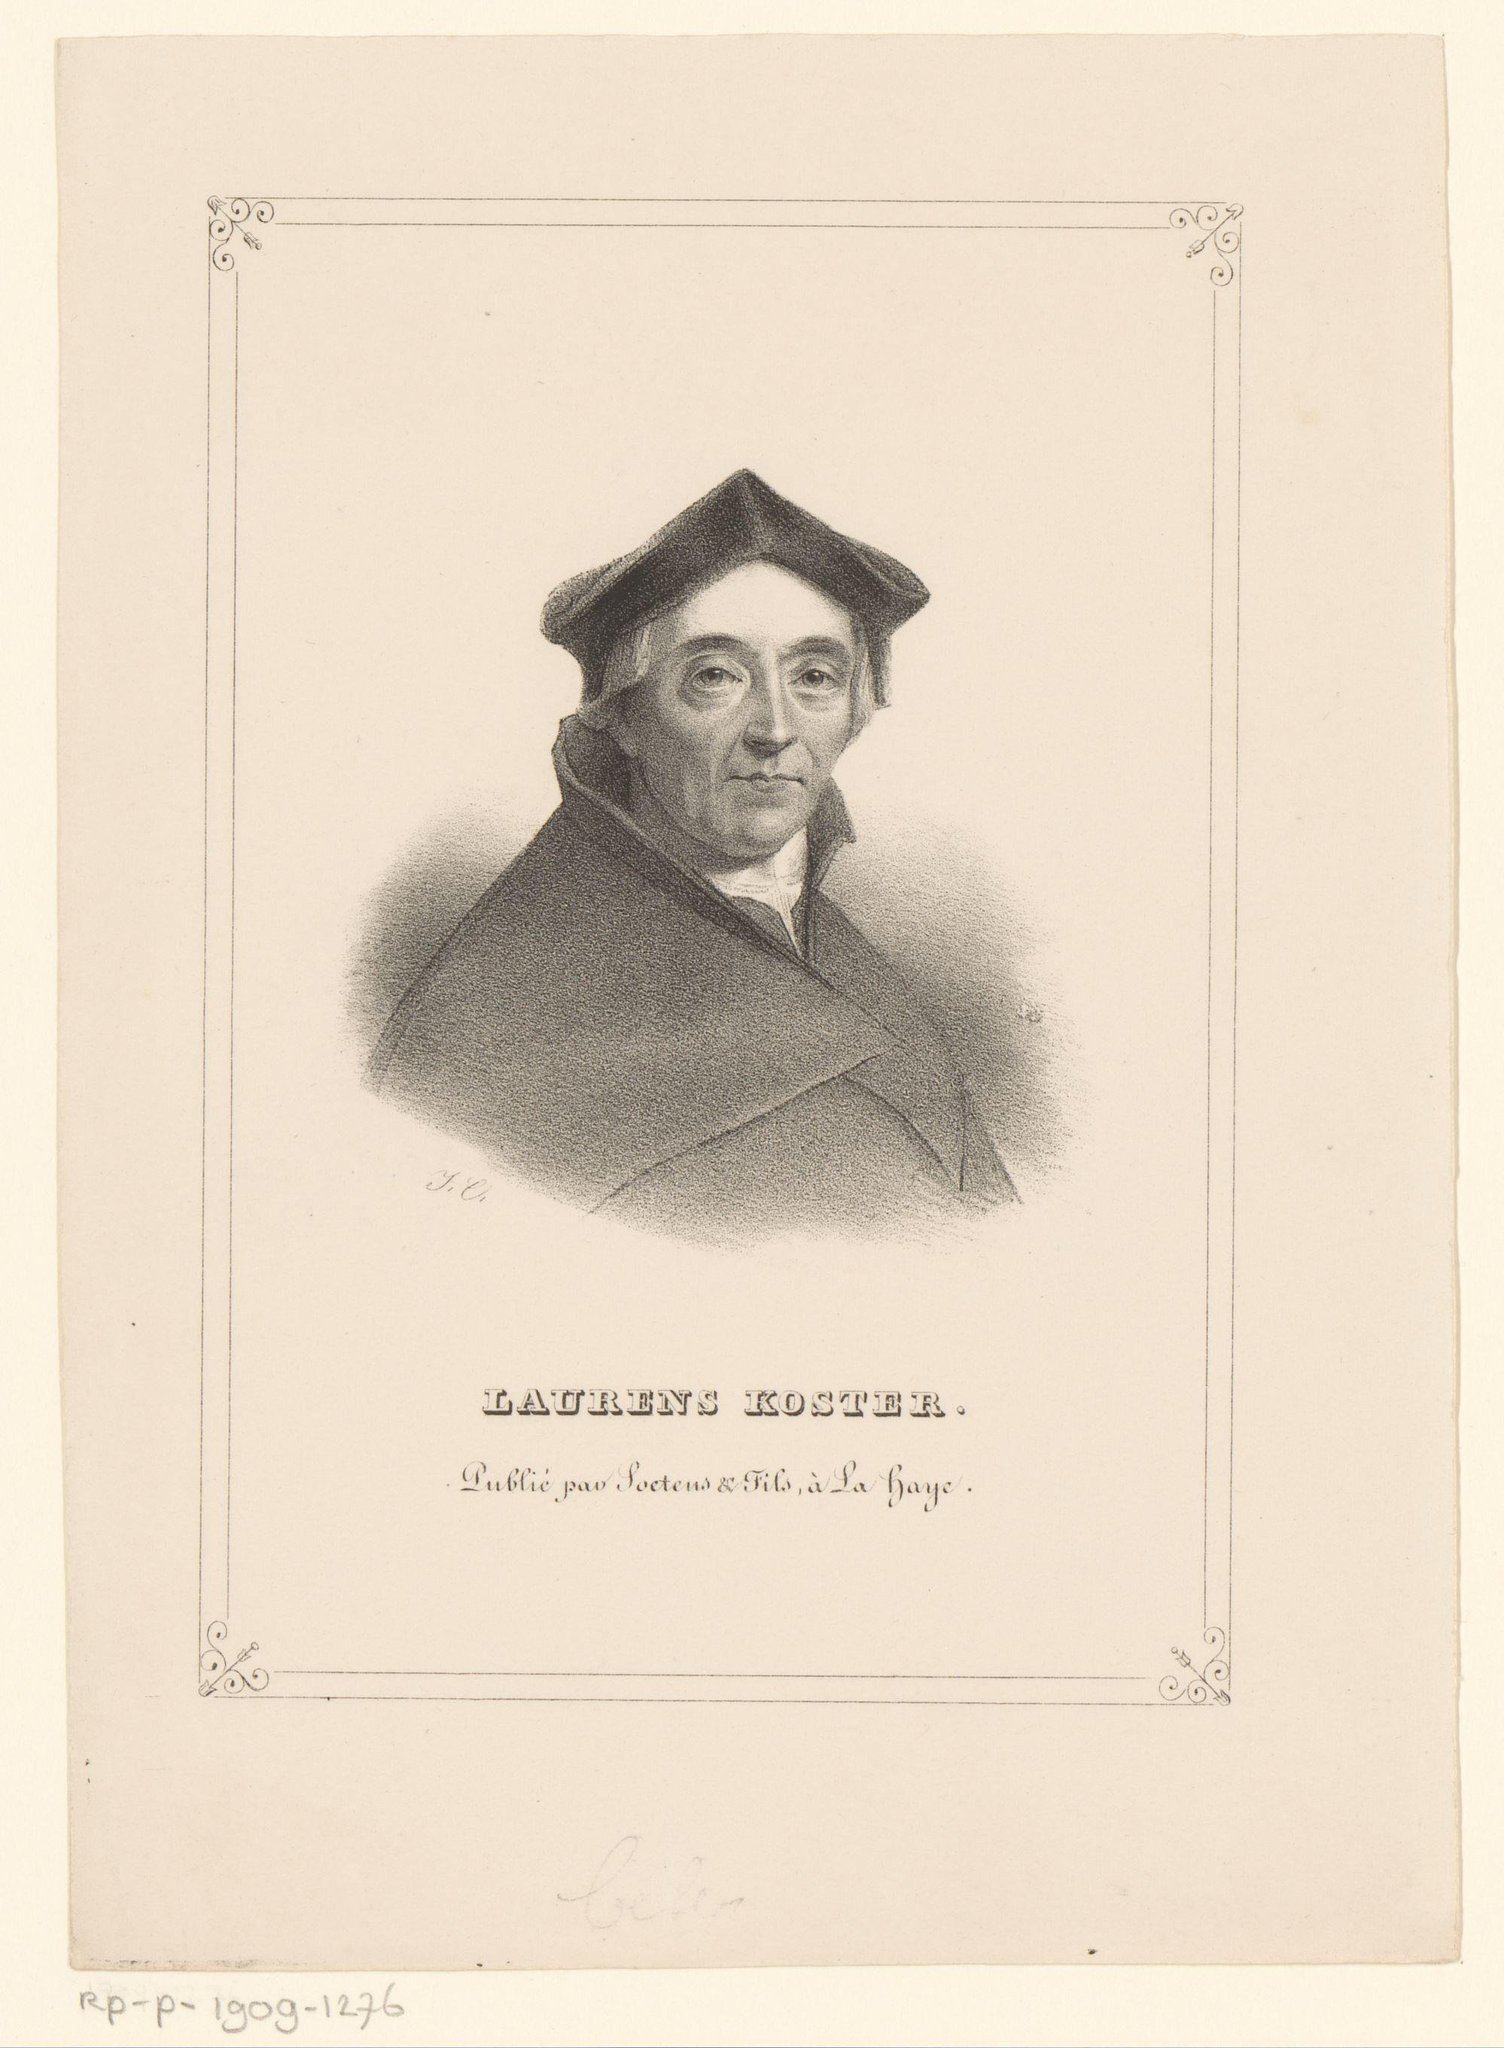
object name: print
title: Portret van Laurens Coster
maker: j.b. clermans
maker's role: print maker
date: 1837-1840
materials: paper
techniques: lithograph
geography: the hague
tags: historical persons (+ (full) bust portrait)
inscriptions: monogram: ‘JC’, collector's mark: Lugt 2228